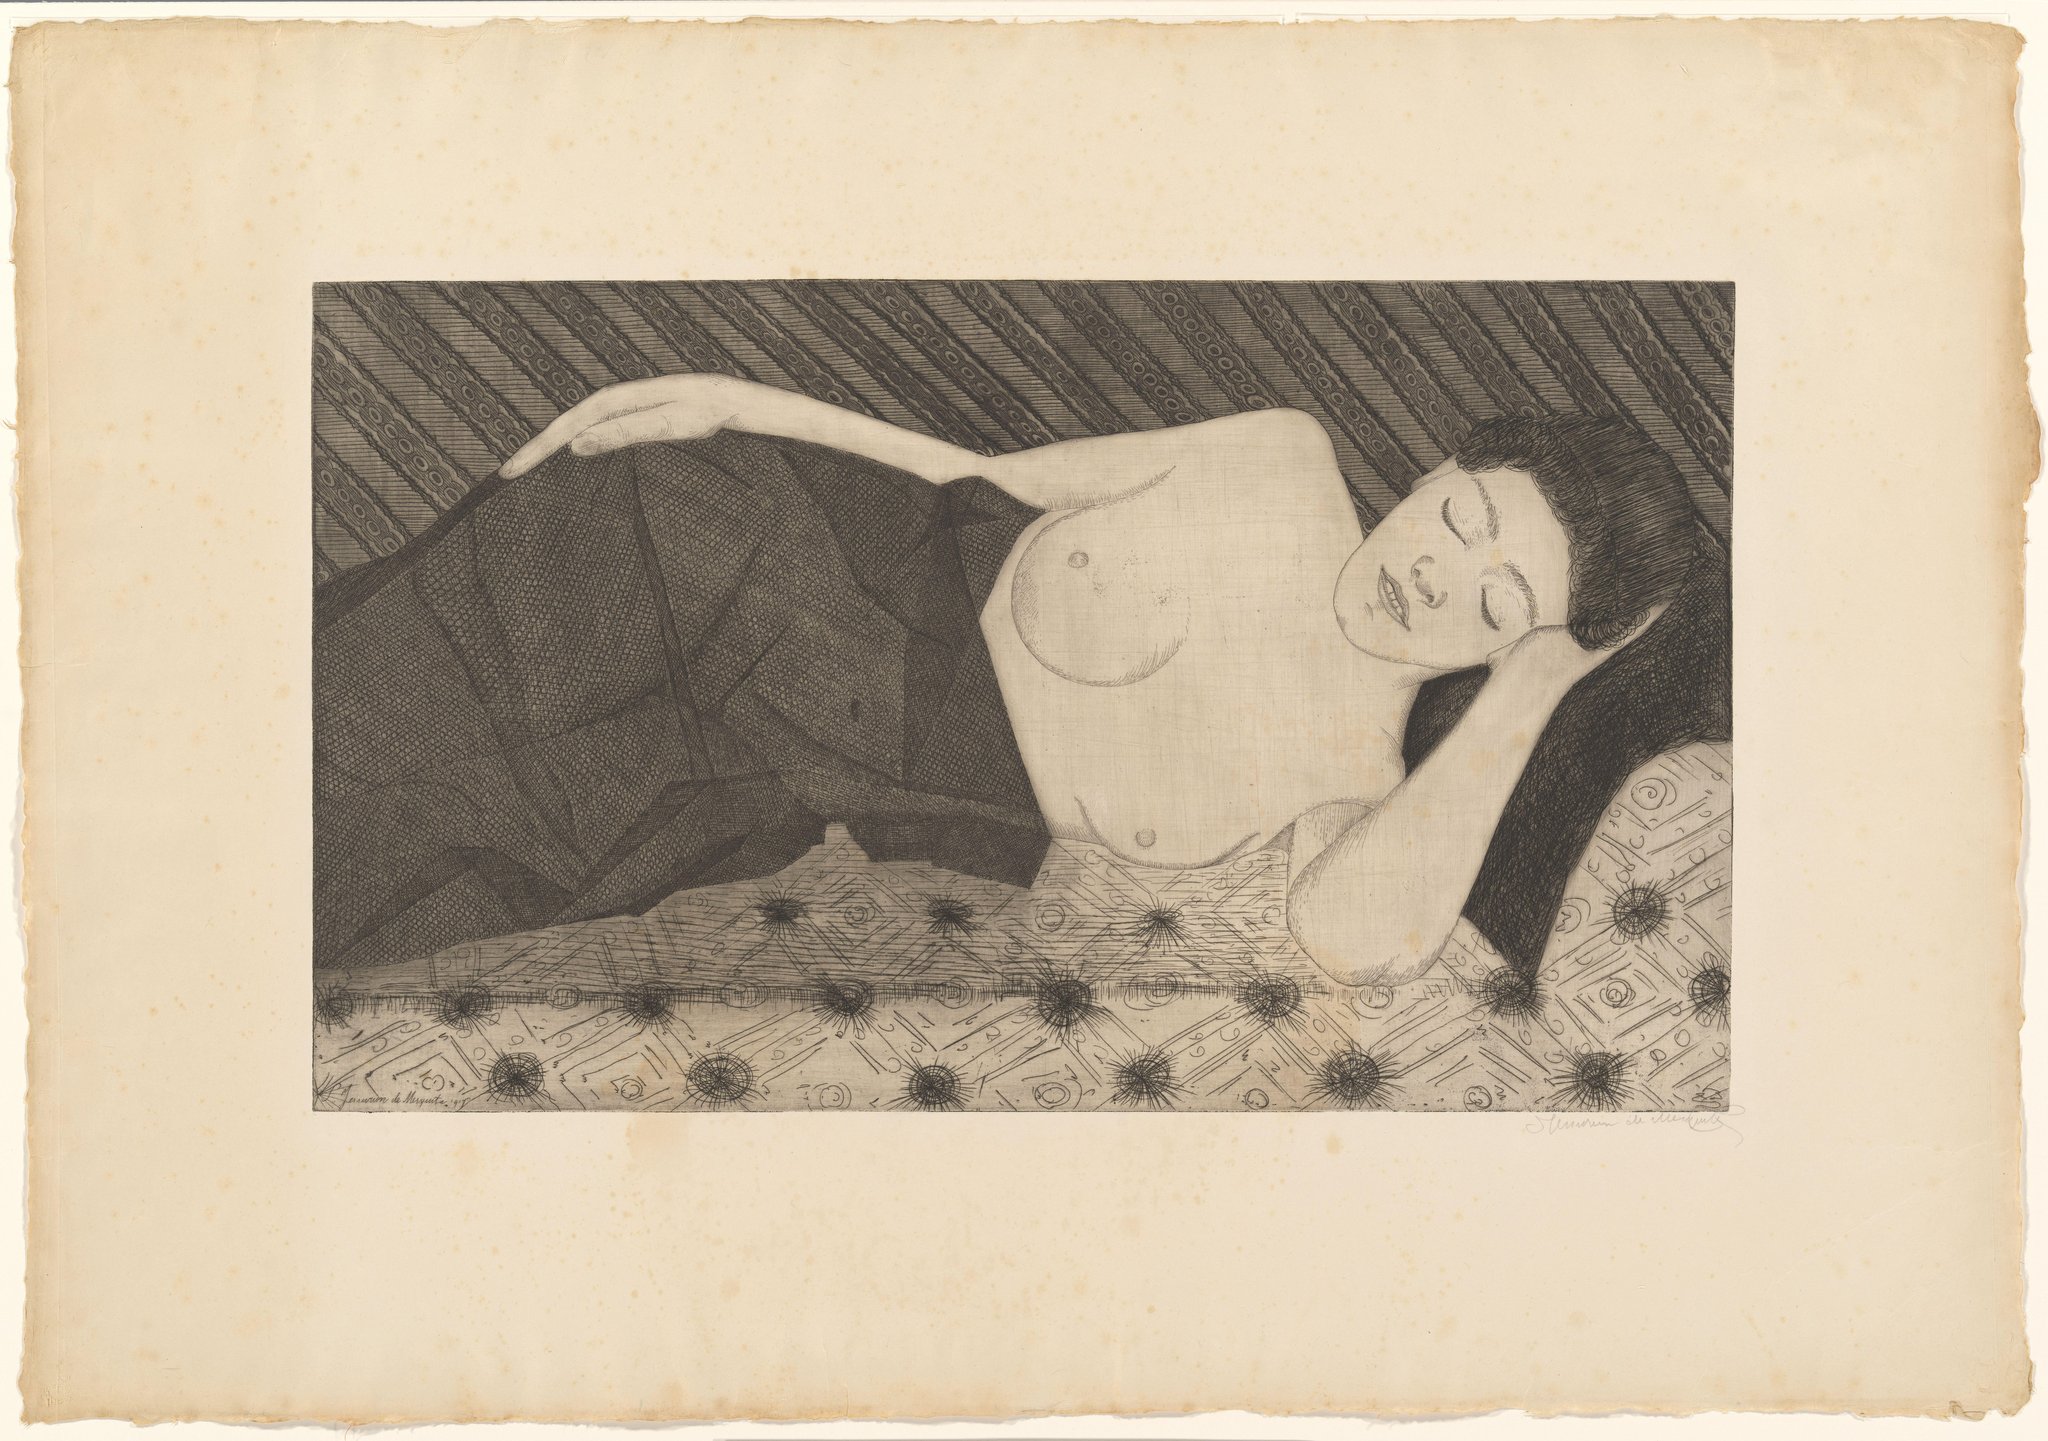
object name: print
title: Naaktfiguur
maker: samuel jessurun de mesquita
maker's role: draughtsman, print maker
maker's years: 1868-1944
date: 1917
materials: paper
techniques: etching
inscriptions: date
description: Hoogstwaarschijnlijk uit de oplage van 30 waarvan niet alle afdrukken werden genummerd (en waarvan slechts 8 andere afdrukken bekend zijn). Voorstudie voor deze ets is in het Rijksmuseum aanwezig [Bosch van Roosenthal, taxatierapport 2009].